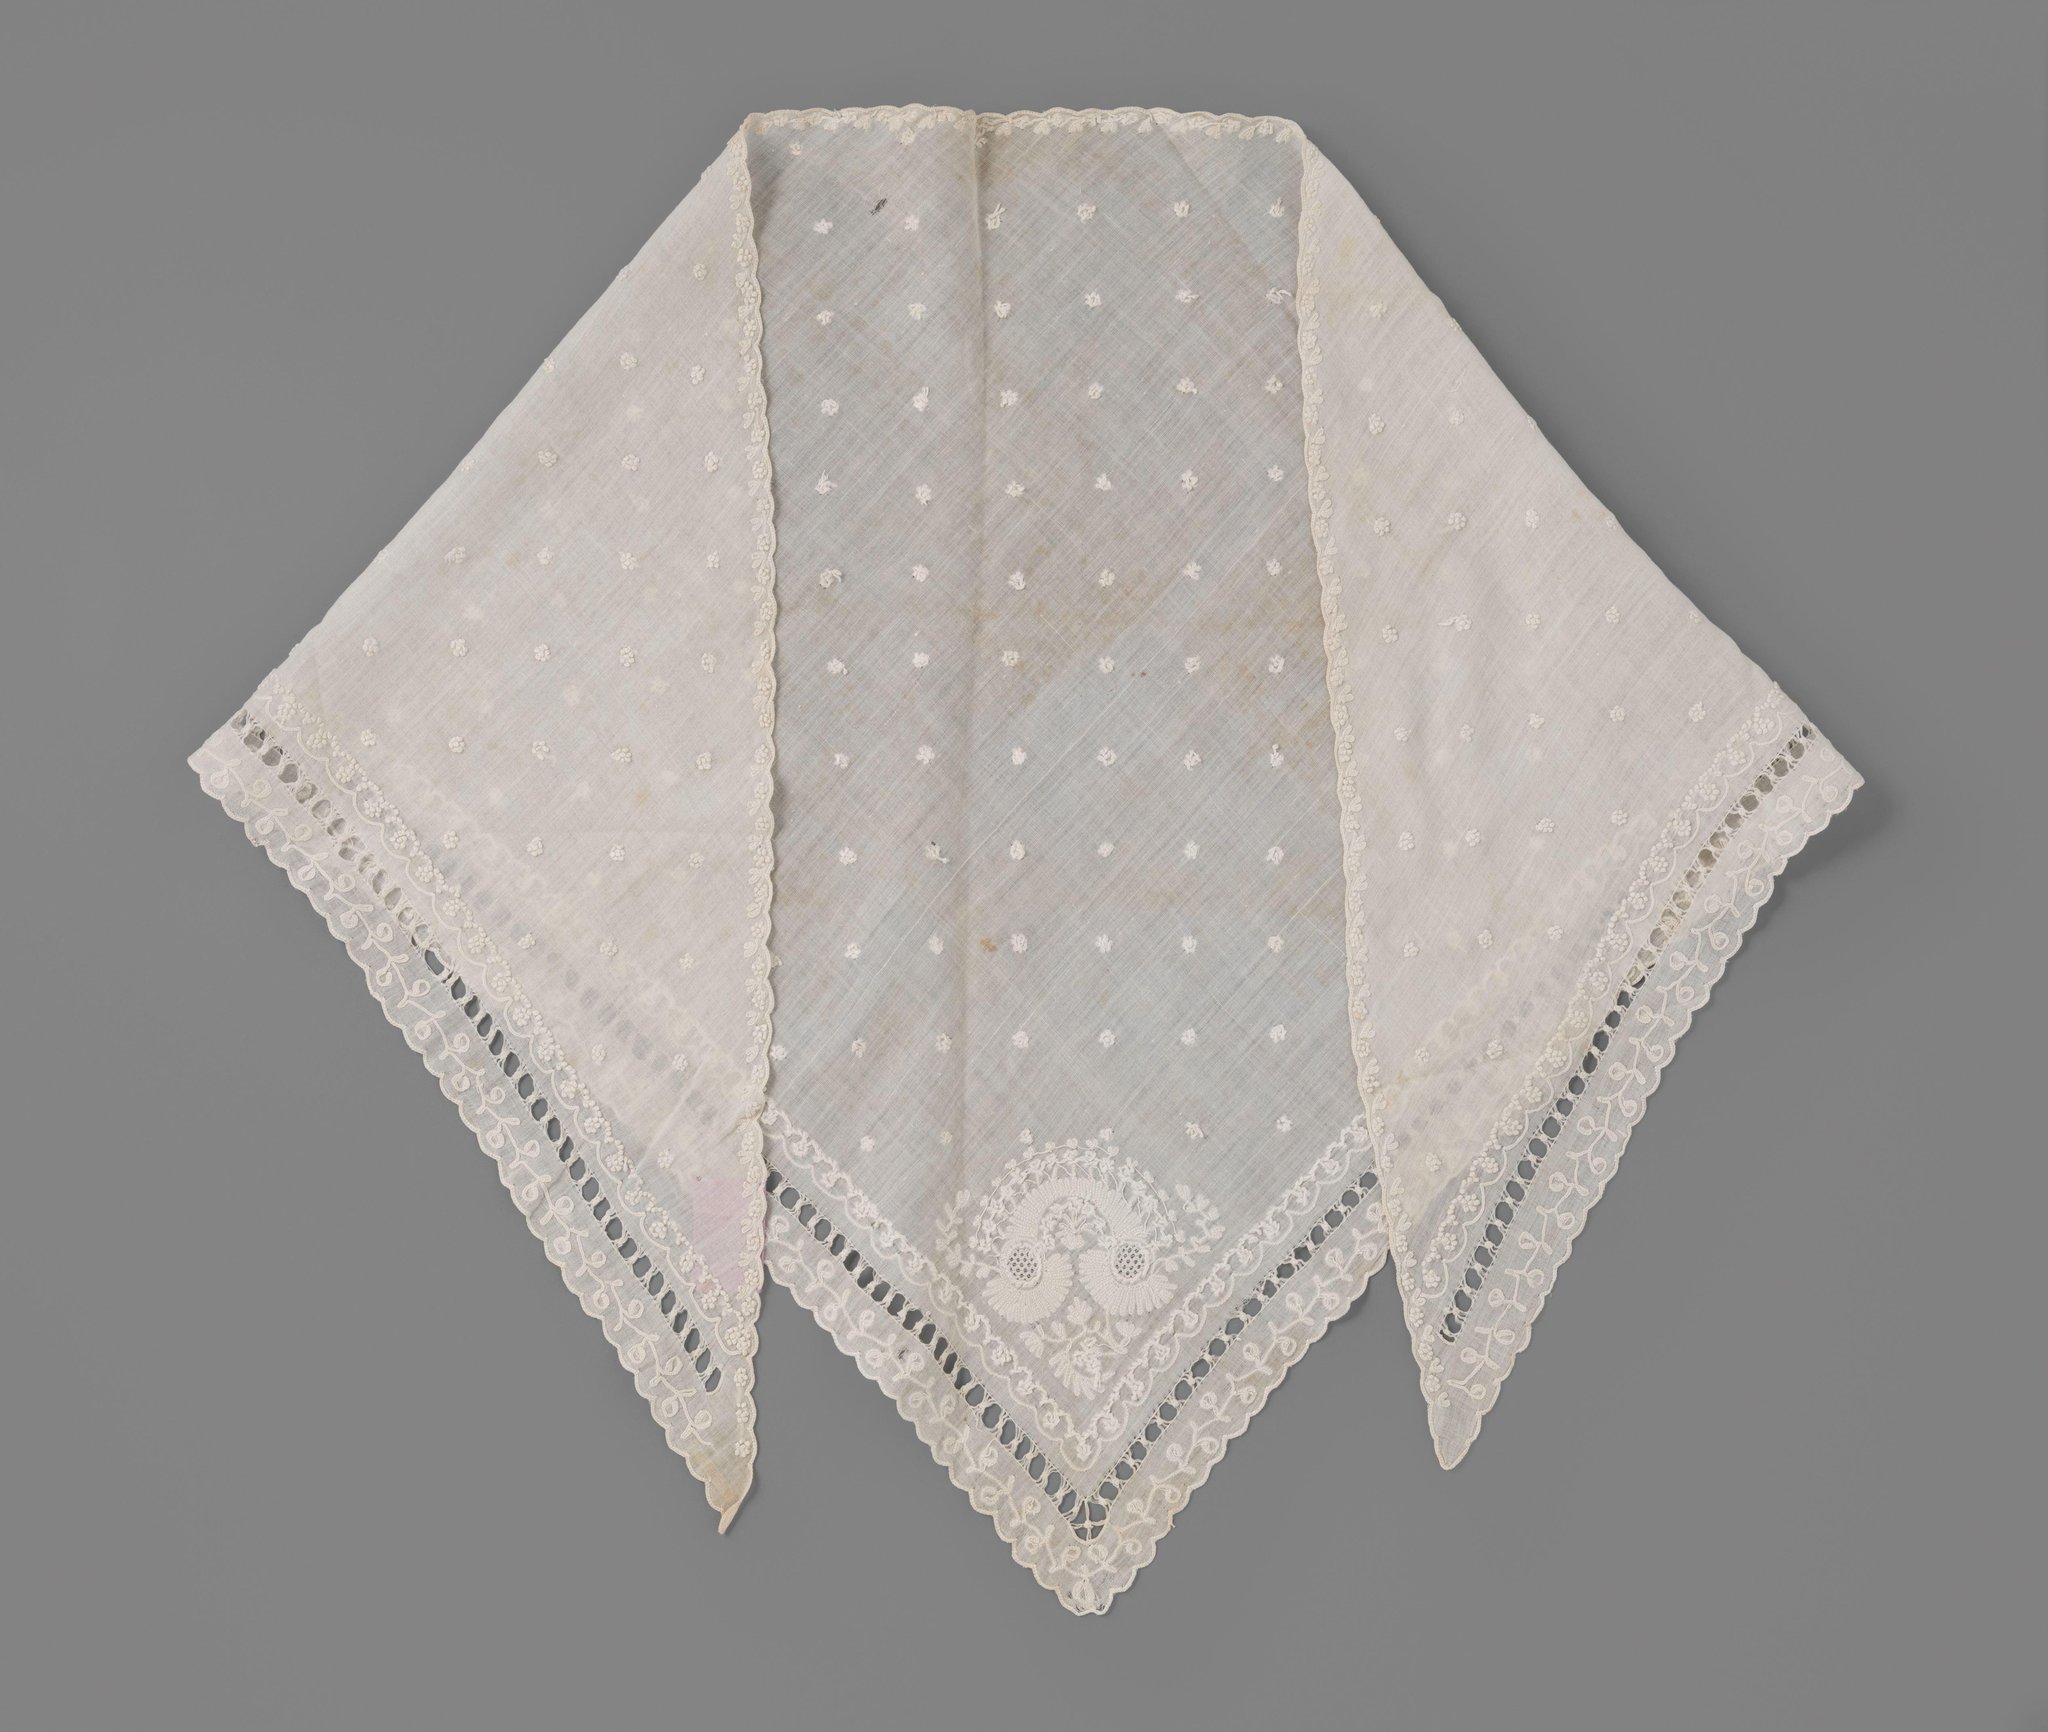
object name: womenswear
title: Fichu van linnen batist, driehoekig, rondom geschulpt en versierd met tamboereerwerk en een tussenzetsel van fils tirés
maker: Anonymous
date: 1880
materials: cotton, linen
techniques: embroidered, weave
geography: netherlands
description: Fichu van linnen batist, driehoekig, rondom geschulpt en versierd met tamboereerwerk en een tussenzetsel van fils tirés. Model: driehoekig, schuin op de draad gewerkt. Versiering: in de punt een symmetrisch ornament samengesteld uit bloemen met getamboereerde bladeren en een hart van knoopjessteek, hieronder een rand met getamboereerde schulpen gevuld met knoopjessteek, waaronder een rand van fils tirés en boven de zoom een getamboereerde slinger. De geschulpte rand is gefestonneerd. De rest van de doek is voorzien van strooimotief van knoopjessteek.